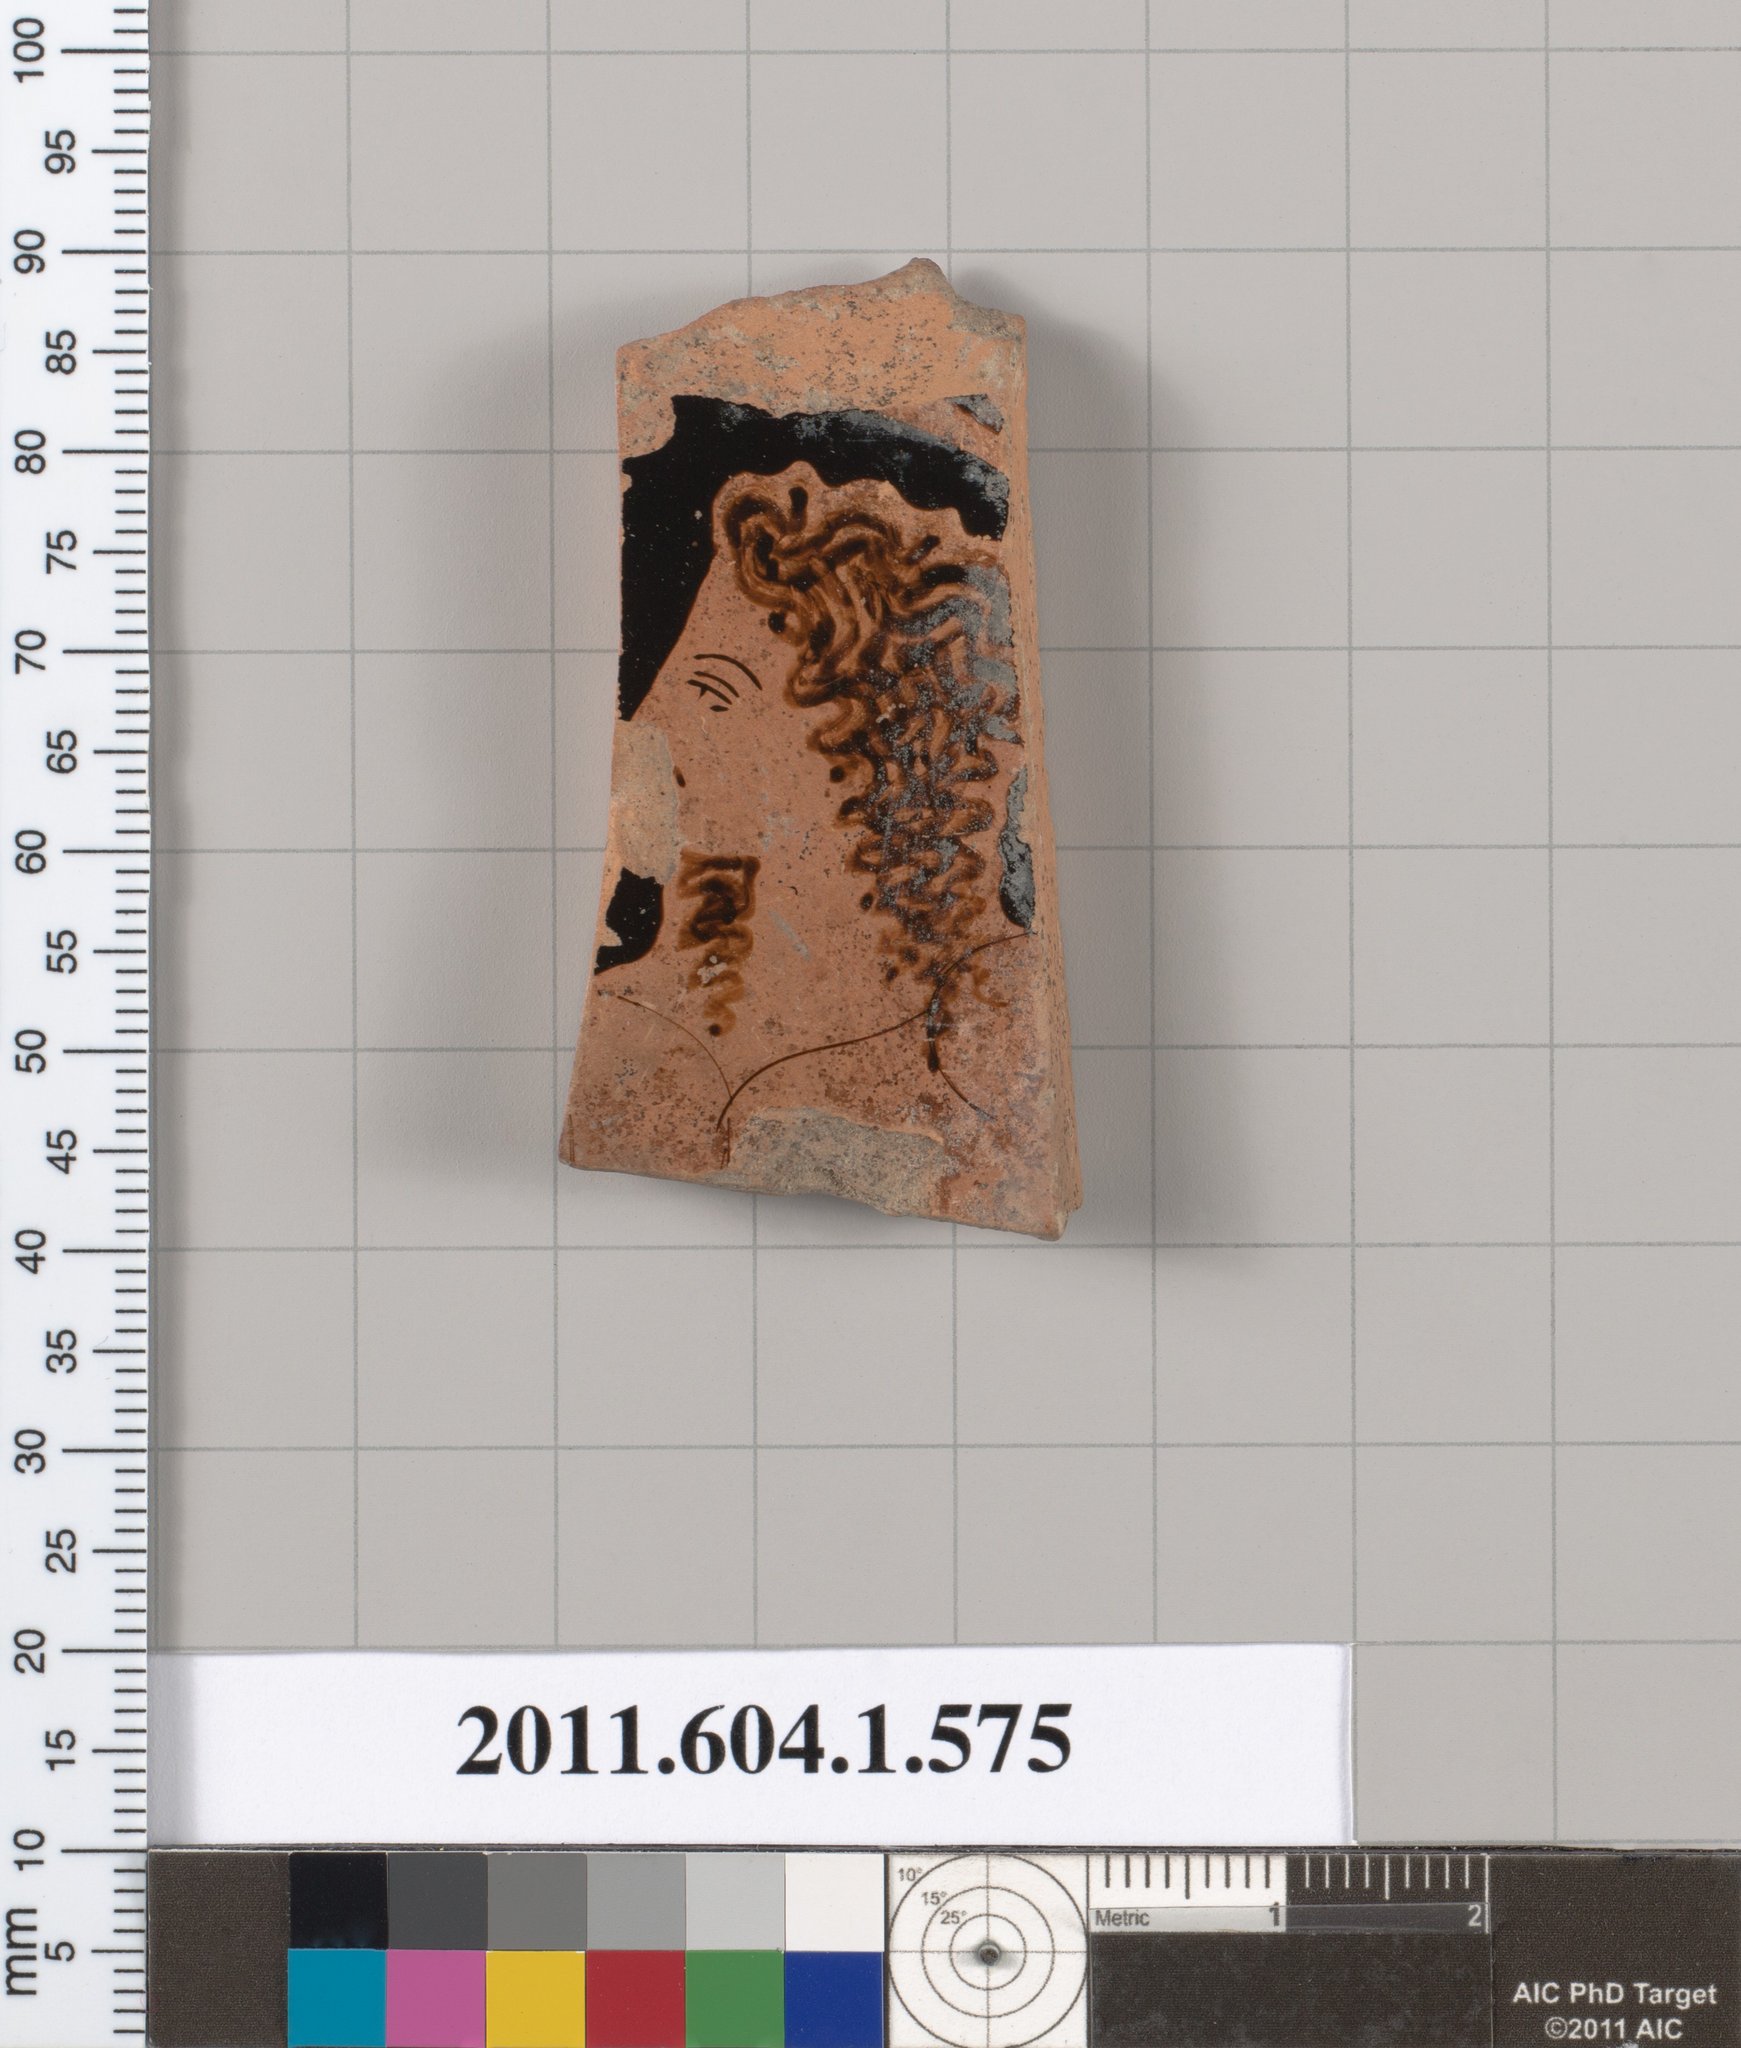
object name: kylix fragment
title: Terracotta fragment of a kylix (drinking cup)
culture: greek, attic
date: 450-401 BCE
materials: terracotta